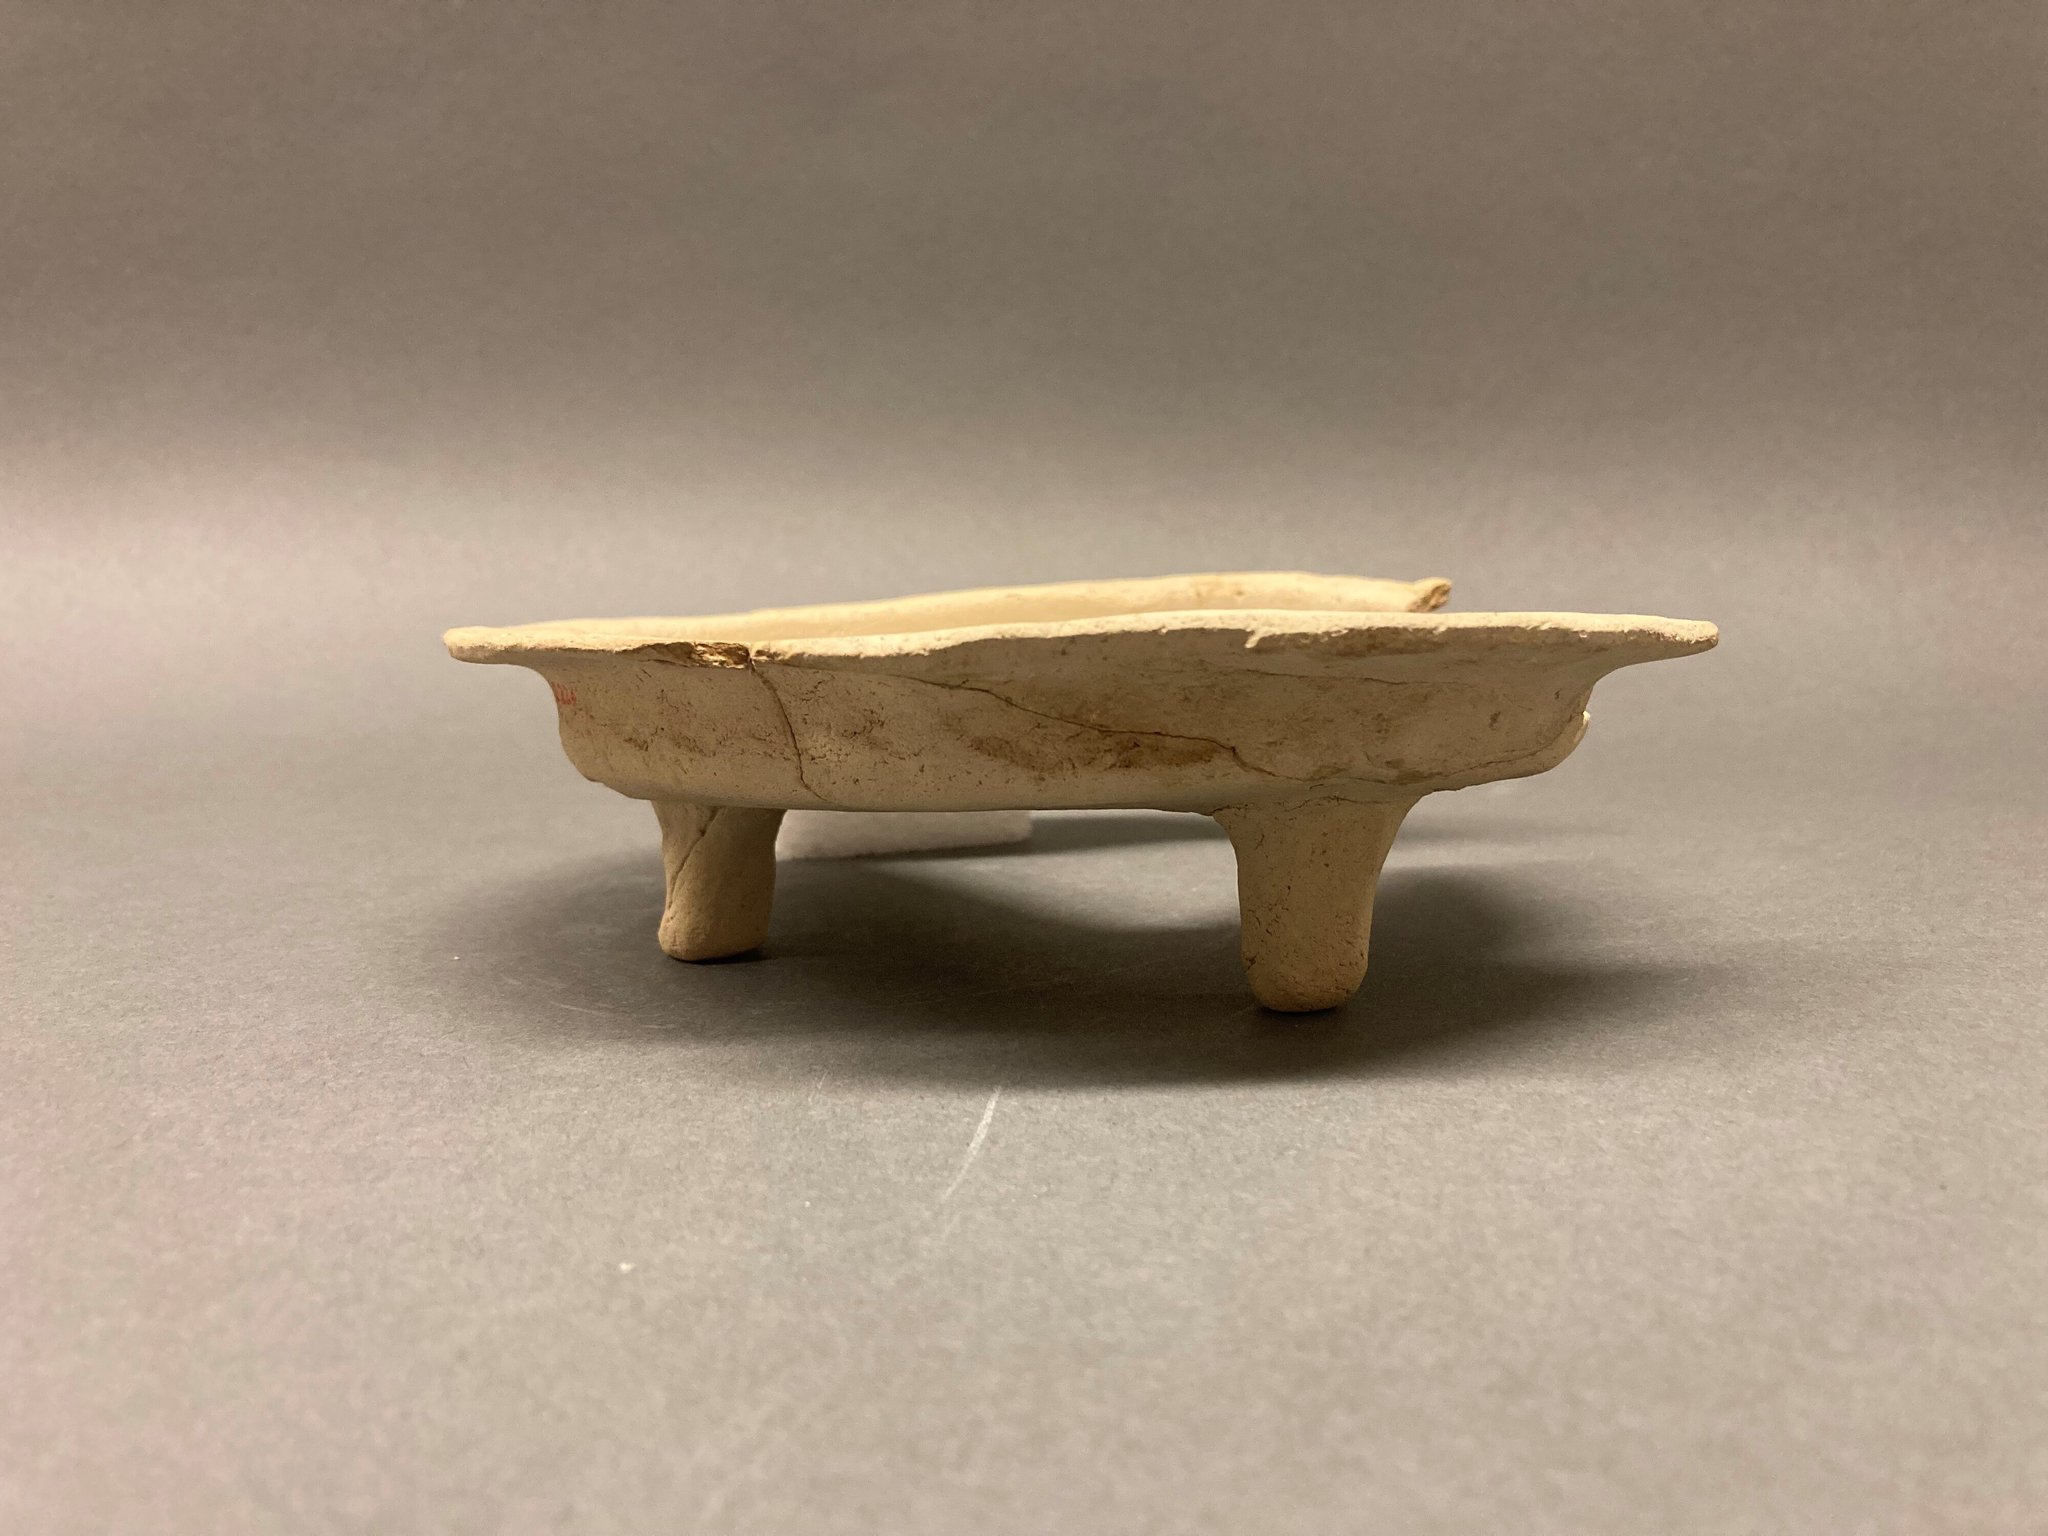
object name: dish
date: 901-1100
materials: earthenware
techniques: incising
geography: iran